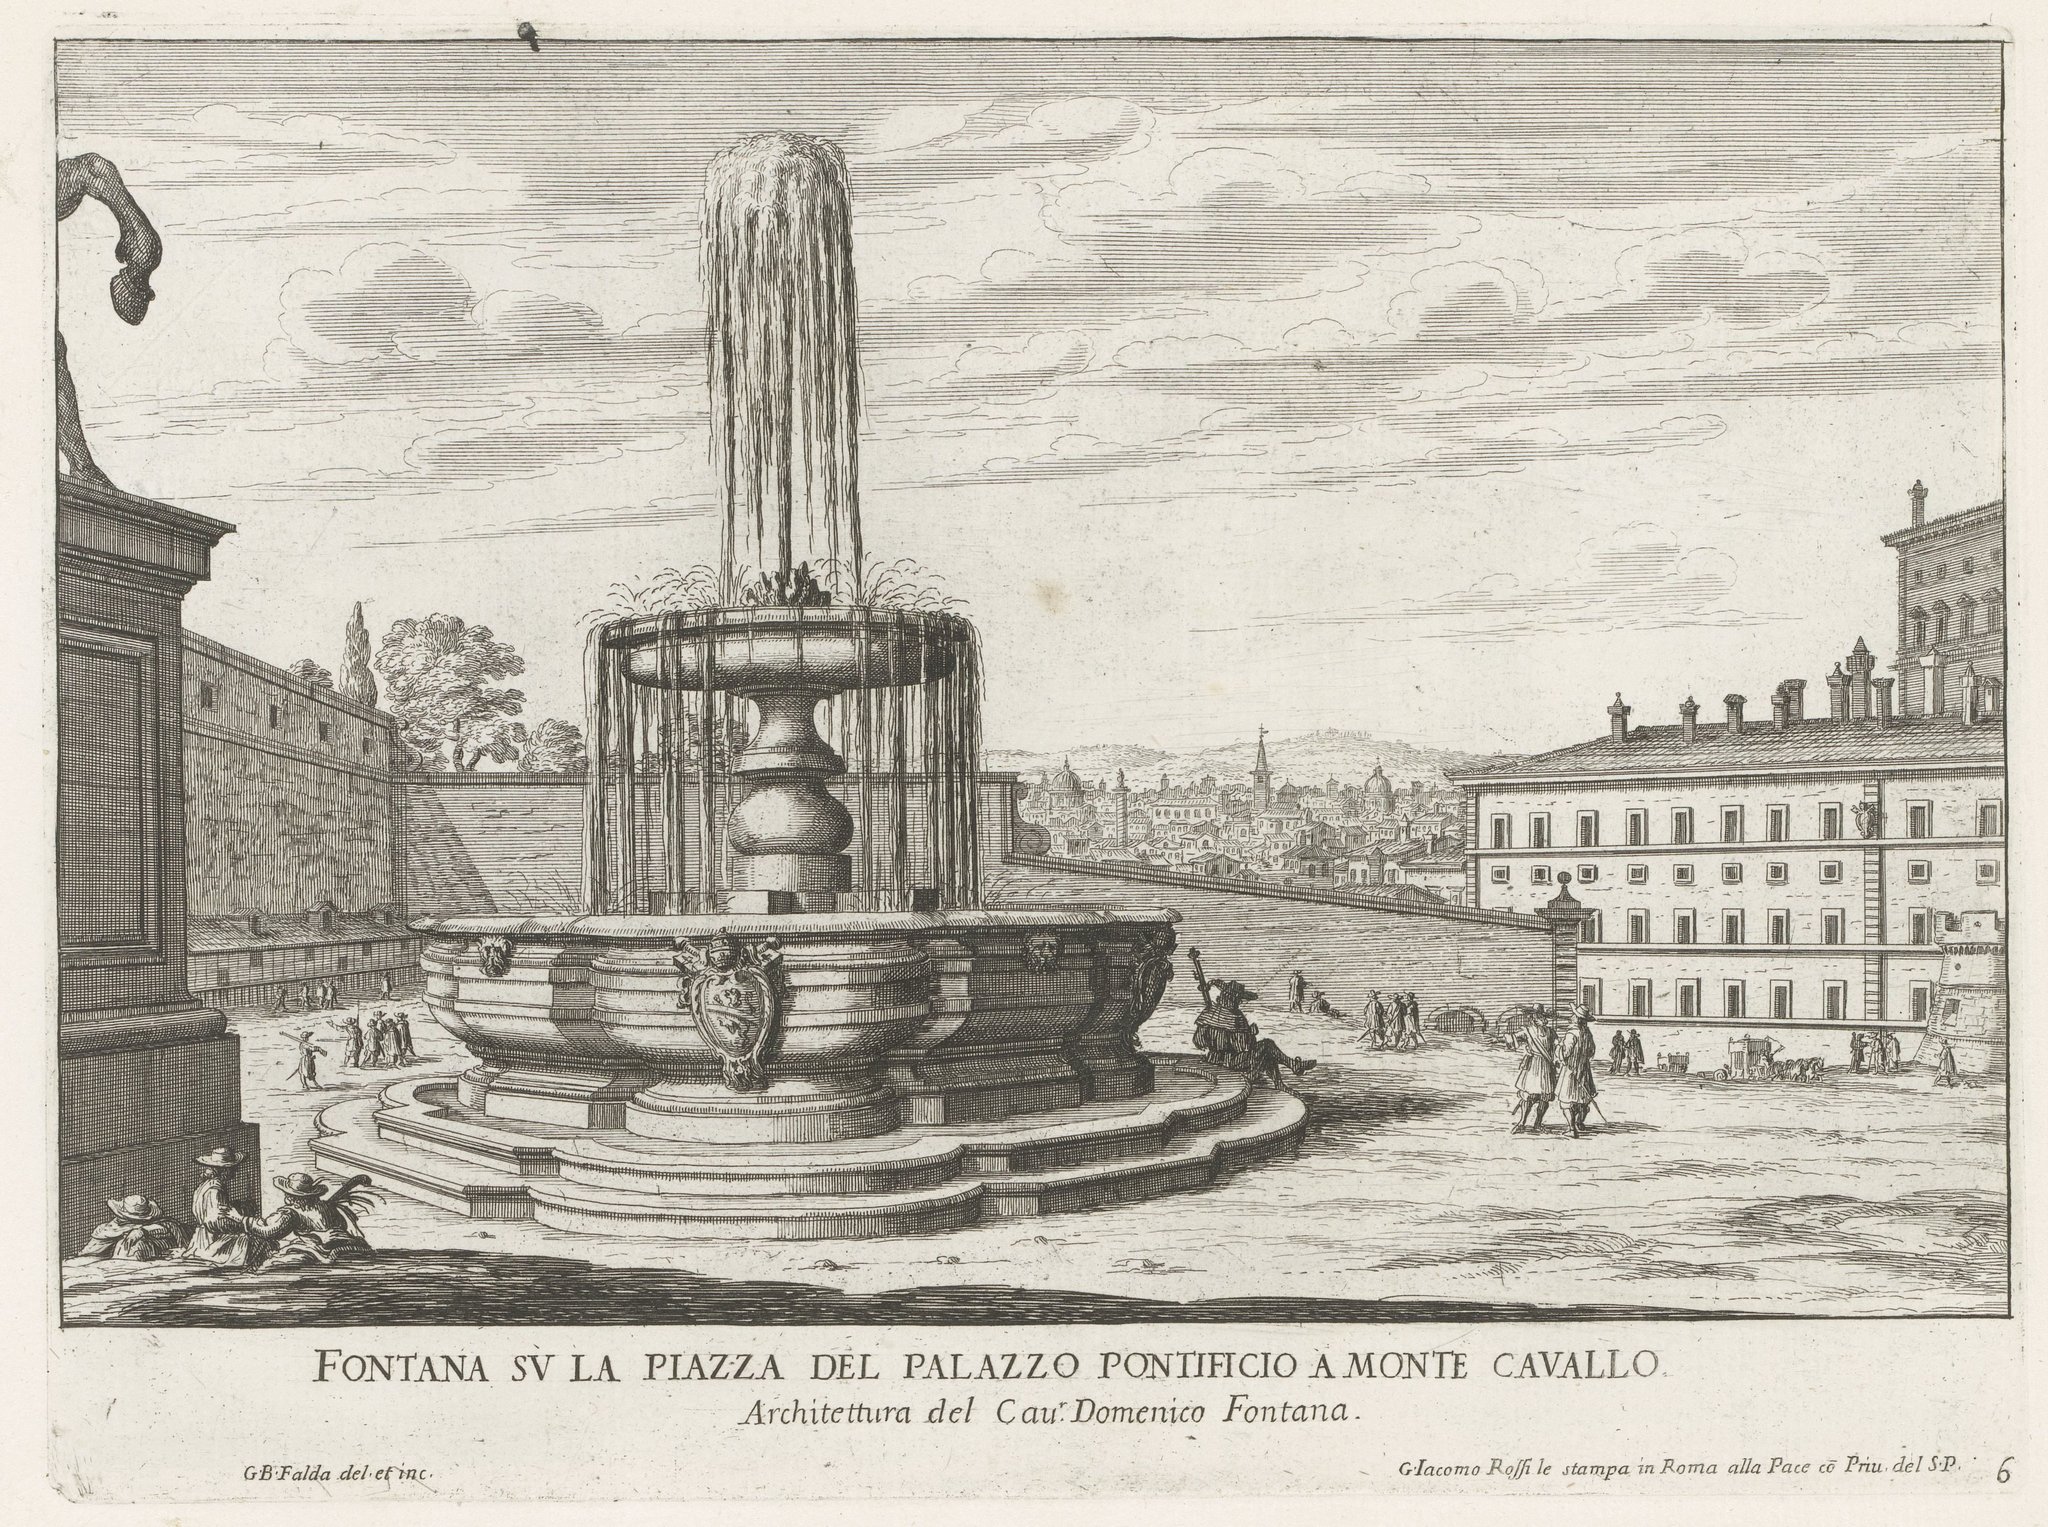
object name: print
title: Fontein op Piazza del Quirinale te Rome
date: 1653-1691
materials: paper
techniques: etching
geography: italy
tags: ornamental fountain, rome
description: Fontein op Piazza del Quirinale op de Quirinaalheuvel. Links is een gedeelte zichtbaar van een van de sculpturen van Castor en Pollux. Genummerd rechtsonder: 6. De prent maakt deel uit van een album.